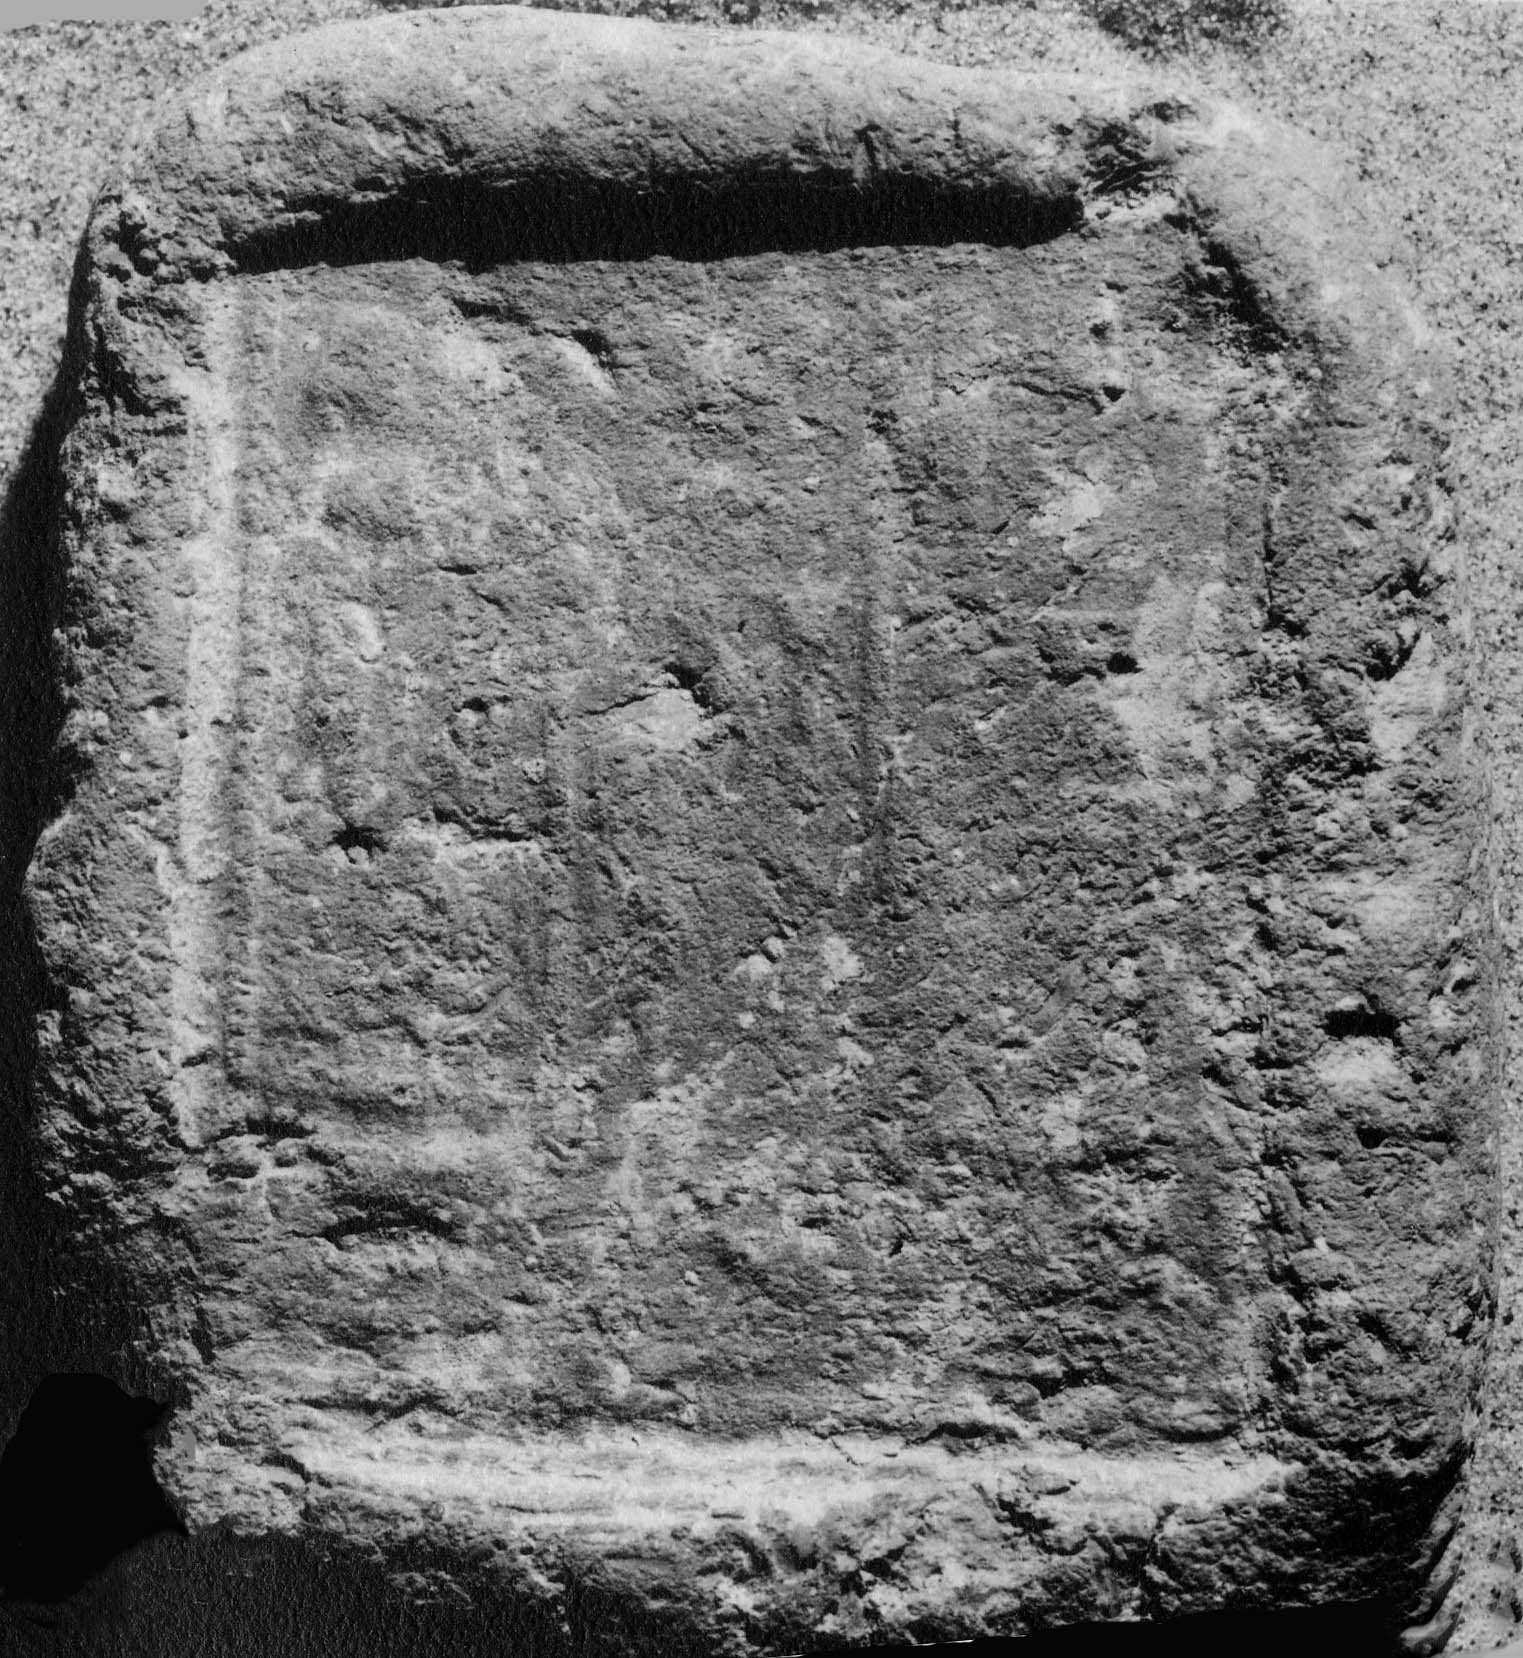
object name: cone, nebamun, scribe, offering teble, butler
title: Funerary Cone of a Scribe of the Offering Table and Butler Named Nebamun.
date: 1550-1295 BCE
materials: pottery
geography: egypt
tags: hieroglyphs